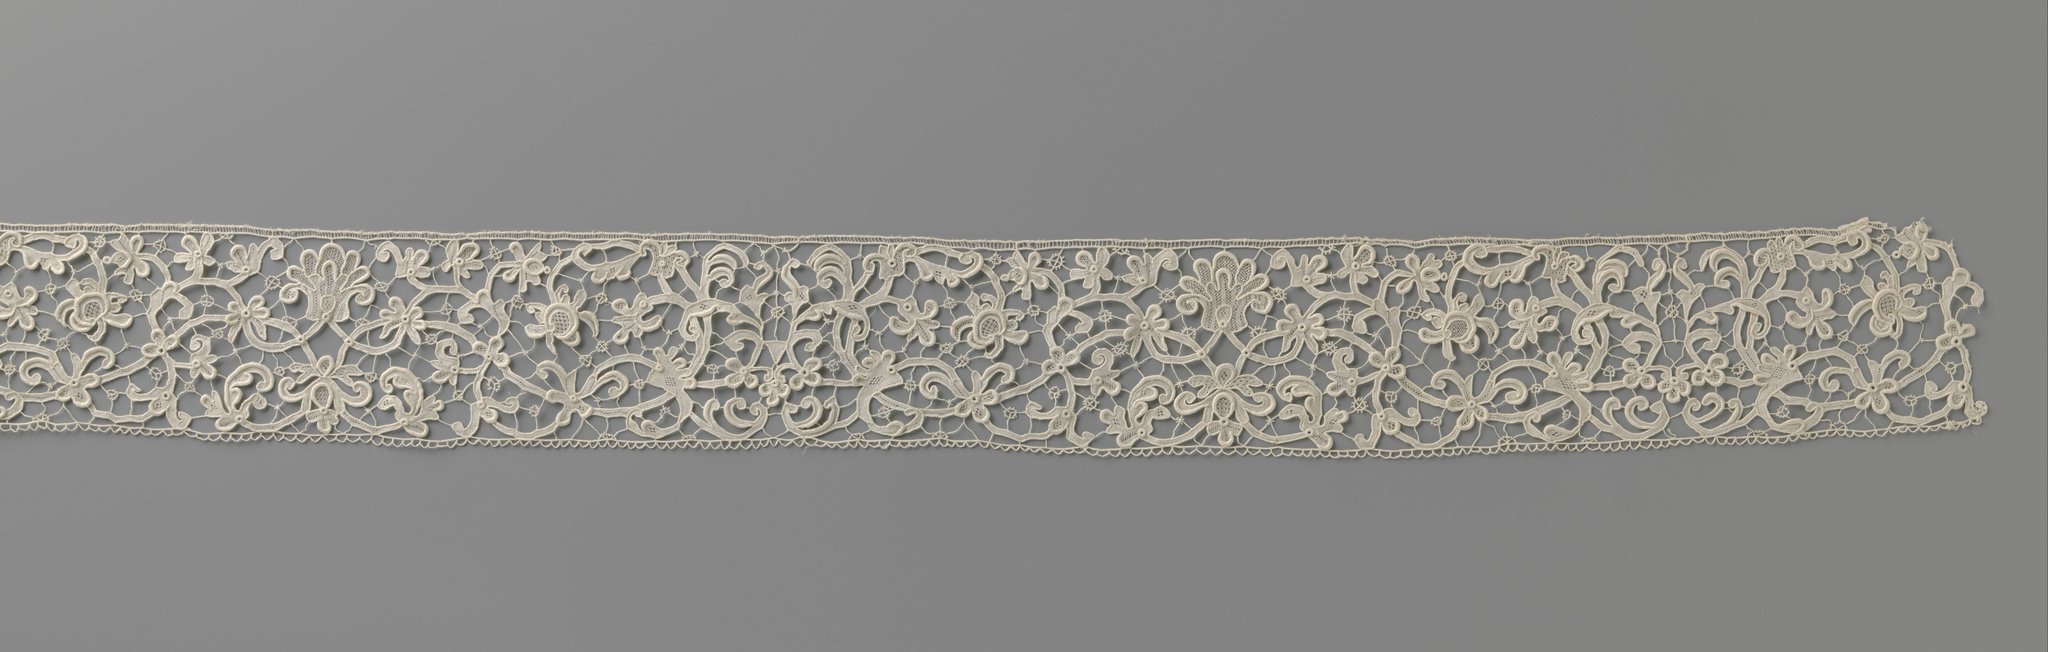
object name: strip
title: Strook naaldkant met kruisende ranken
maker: Anonymous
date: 1900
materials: linen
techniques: rose point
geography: belgium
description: Strook naturelkleurige naaldkant: Venetiaanse rozenkant. Op een open grond van meest gladde spijlen staat een symmetrisch patroon van wijd gespreide ranken, die elkaar veelvuldig kruisen. Op de assen van symmetrie staat afwisselend een waaierplant en een groep van drie hangende klaverblaadjes.